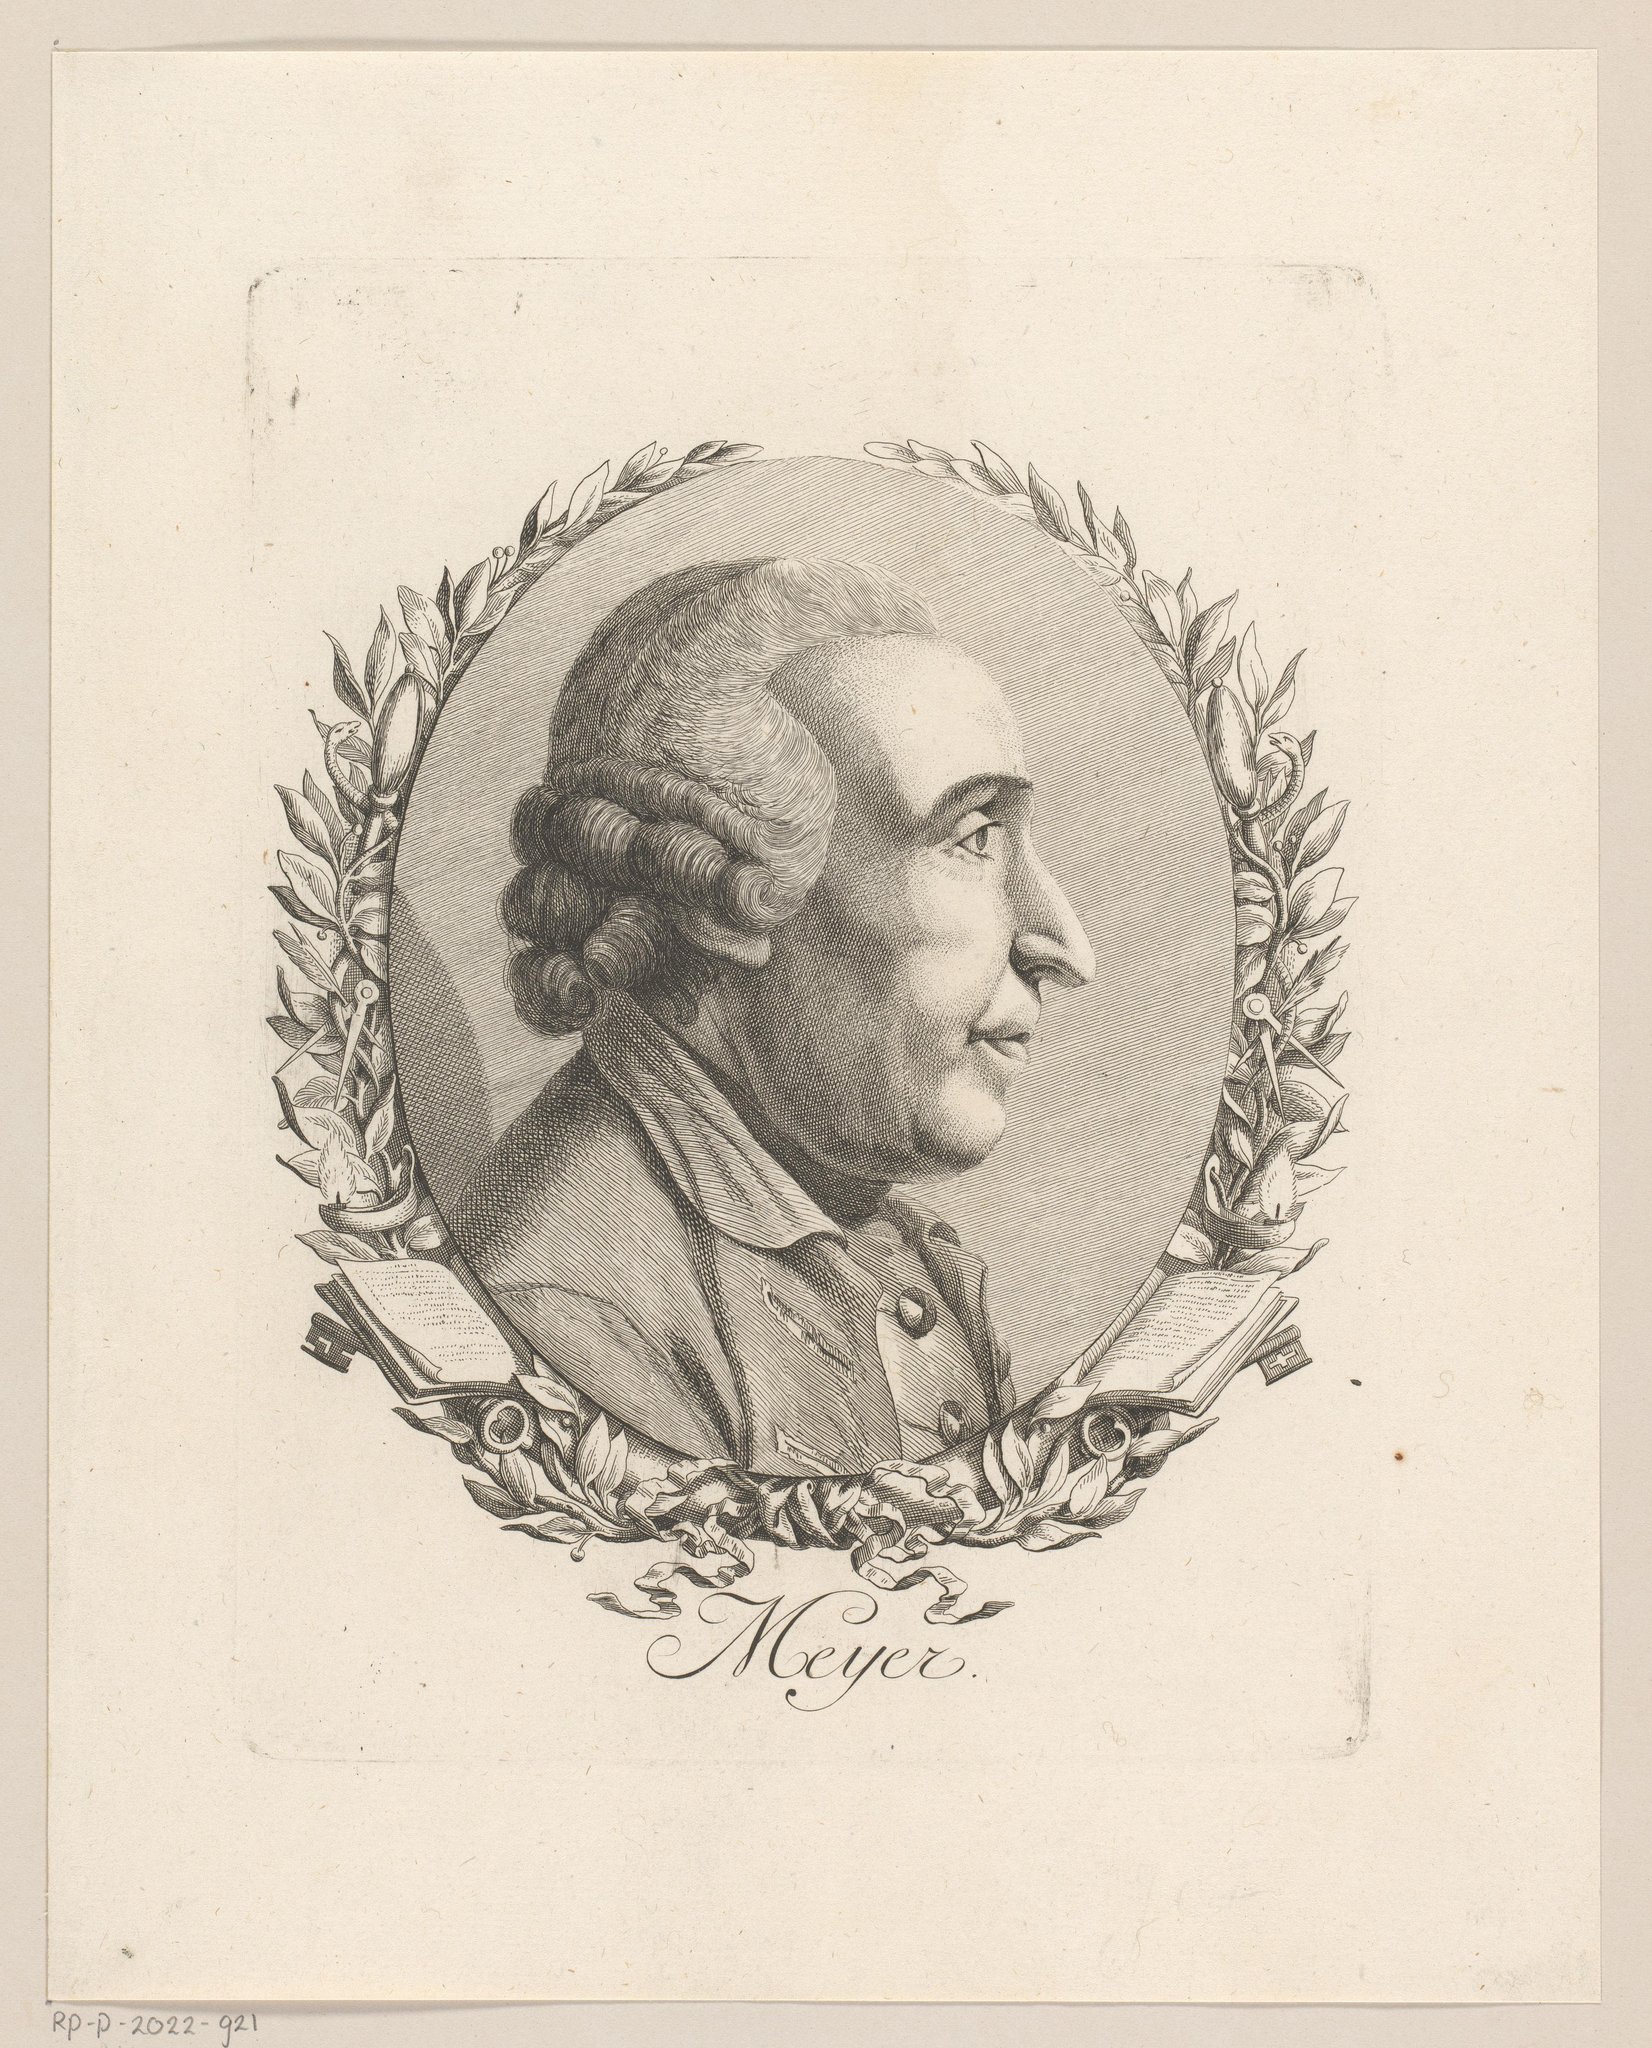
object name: print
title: Portret van Johann Carl Friedrich Meyer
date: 1780-1817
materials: paper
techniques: etching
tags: berlin, chemistry (+ portrait of scholar, scientist), historical persons